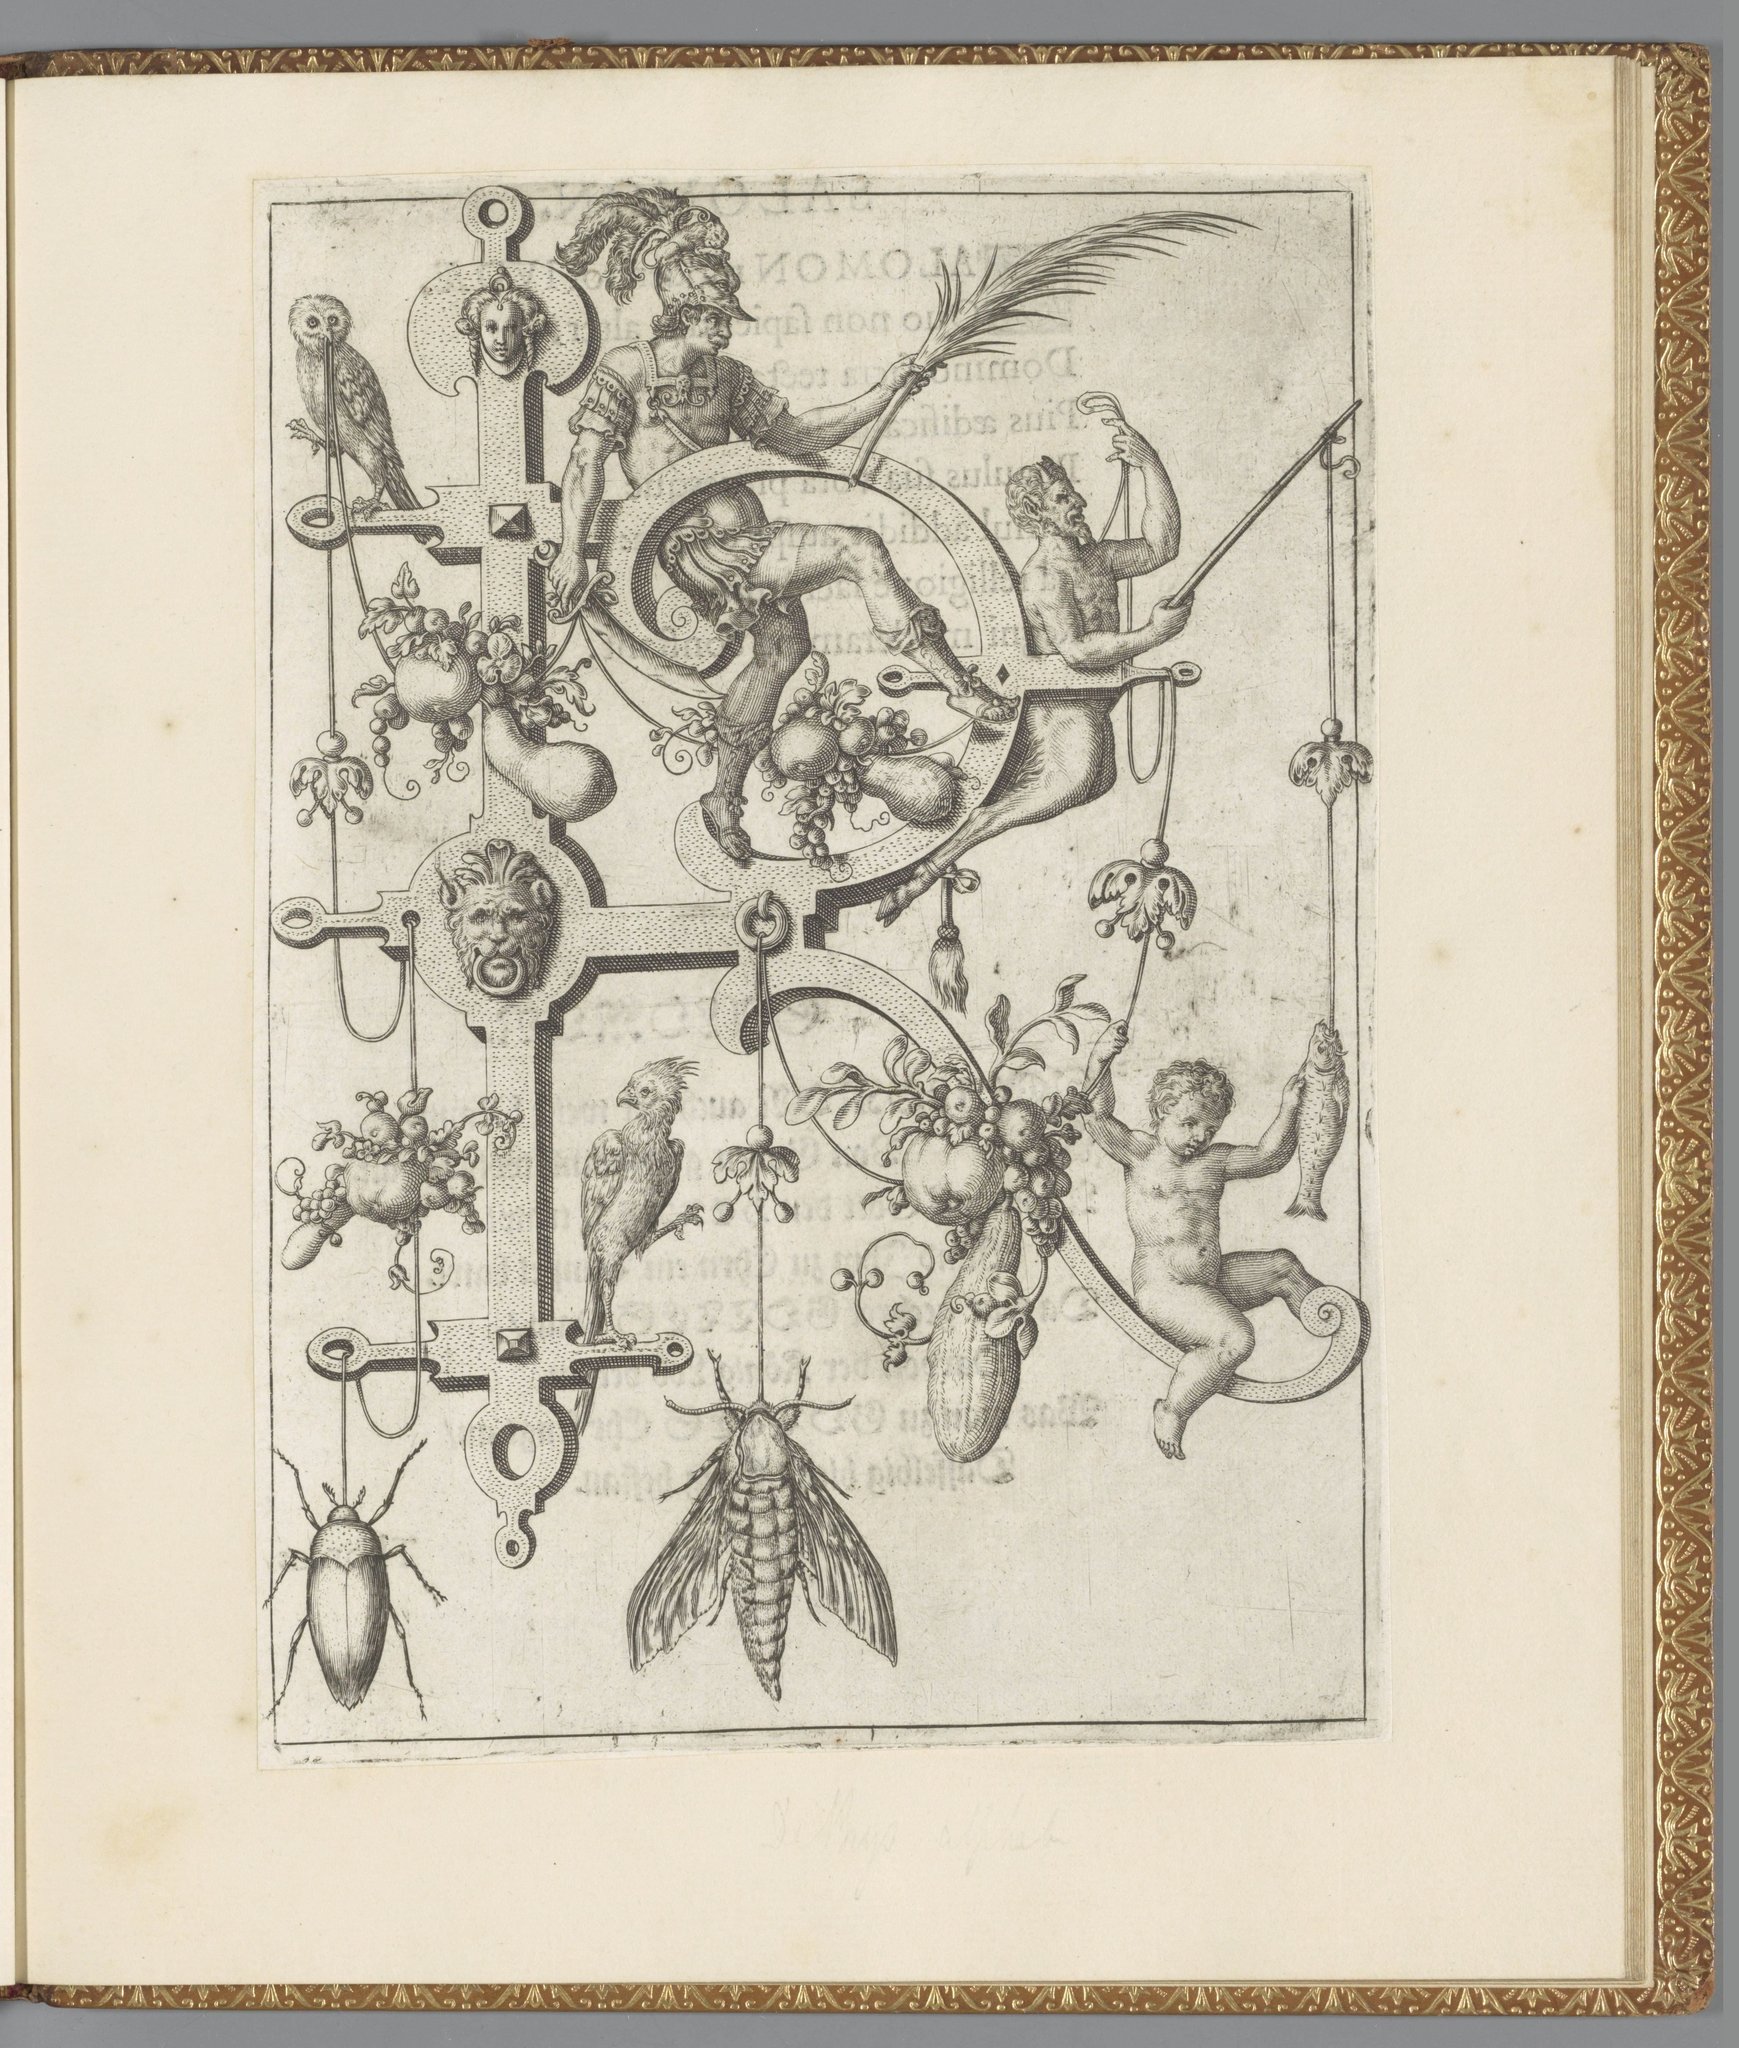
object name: album leaf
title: Nova Alphati Effictio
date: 1595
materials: paper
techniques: engraving, letterpress printing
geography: frankfurt am main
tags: fruits and vegetables ~ ornament, story of rehoboam, king of judah (1 kings 12:21-24, 14:21-31), letters, alphabet, script, insects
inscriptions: collector's mark: Lugt 2228, collector's mark: Lugt 2760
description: Ornamentele letter R met bovenaan koning Rechabeam van Juda gekleed in wapenrusting met zwaard en palmtak in de handen. Rechtsonder een naakte putto met een vis in handen. De letter is verder versierd met vogels, een vlieg, een kever, trossen vruchten en maskers. Op verso verzen in het Latijn en het Duits. Prent maakt deel uit van een album.